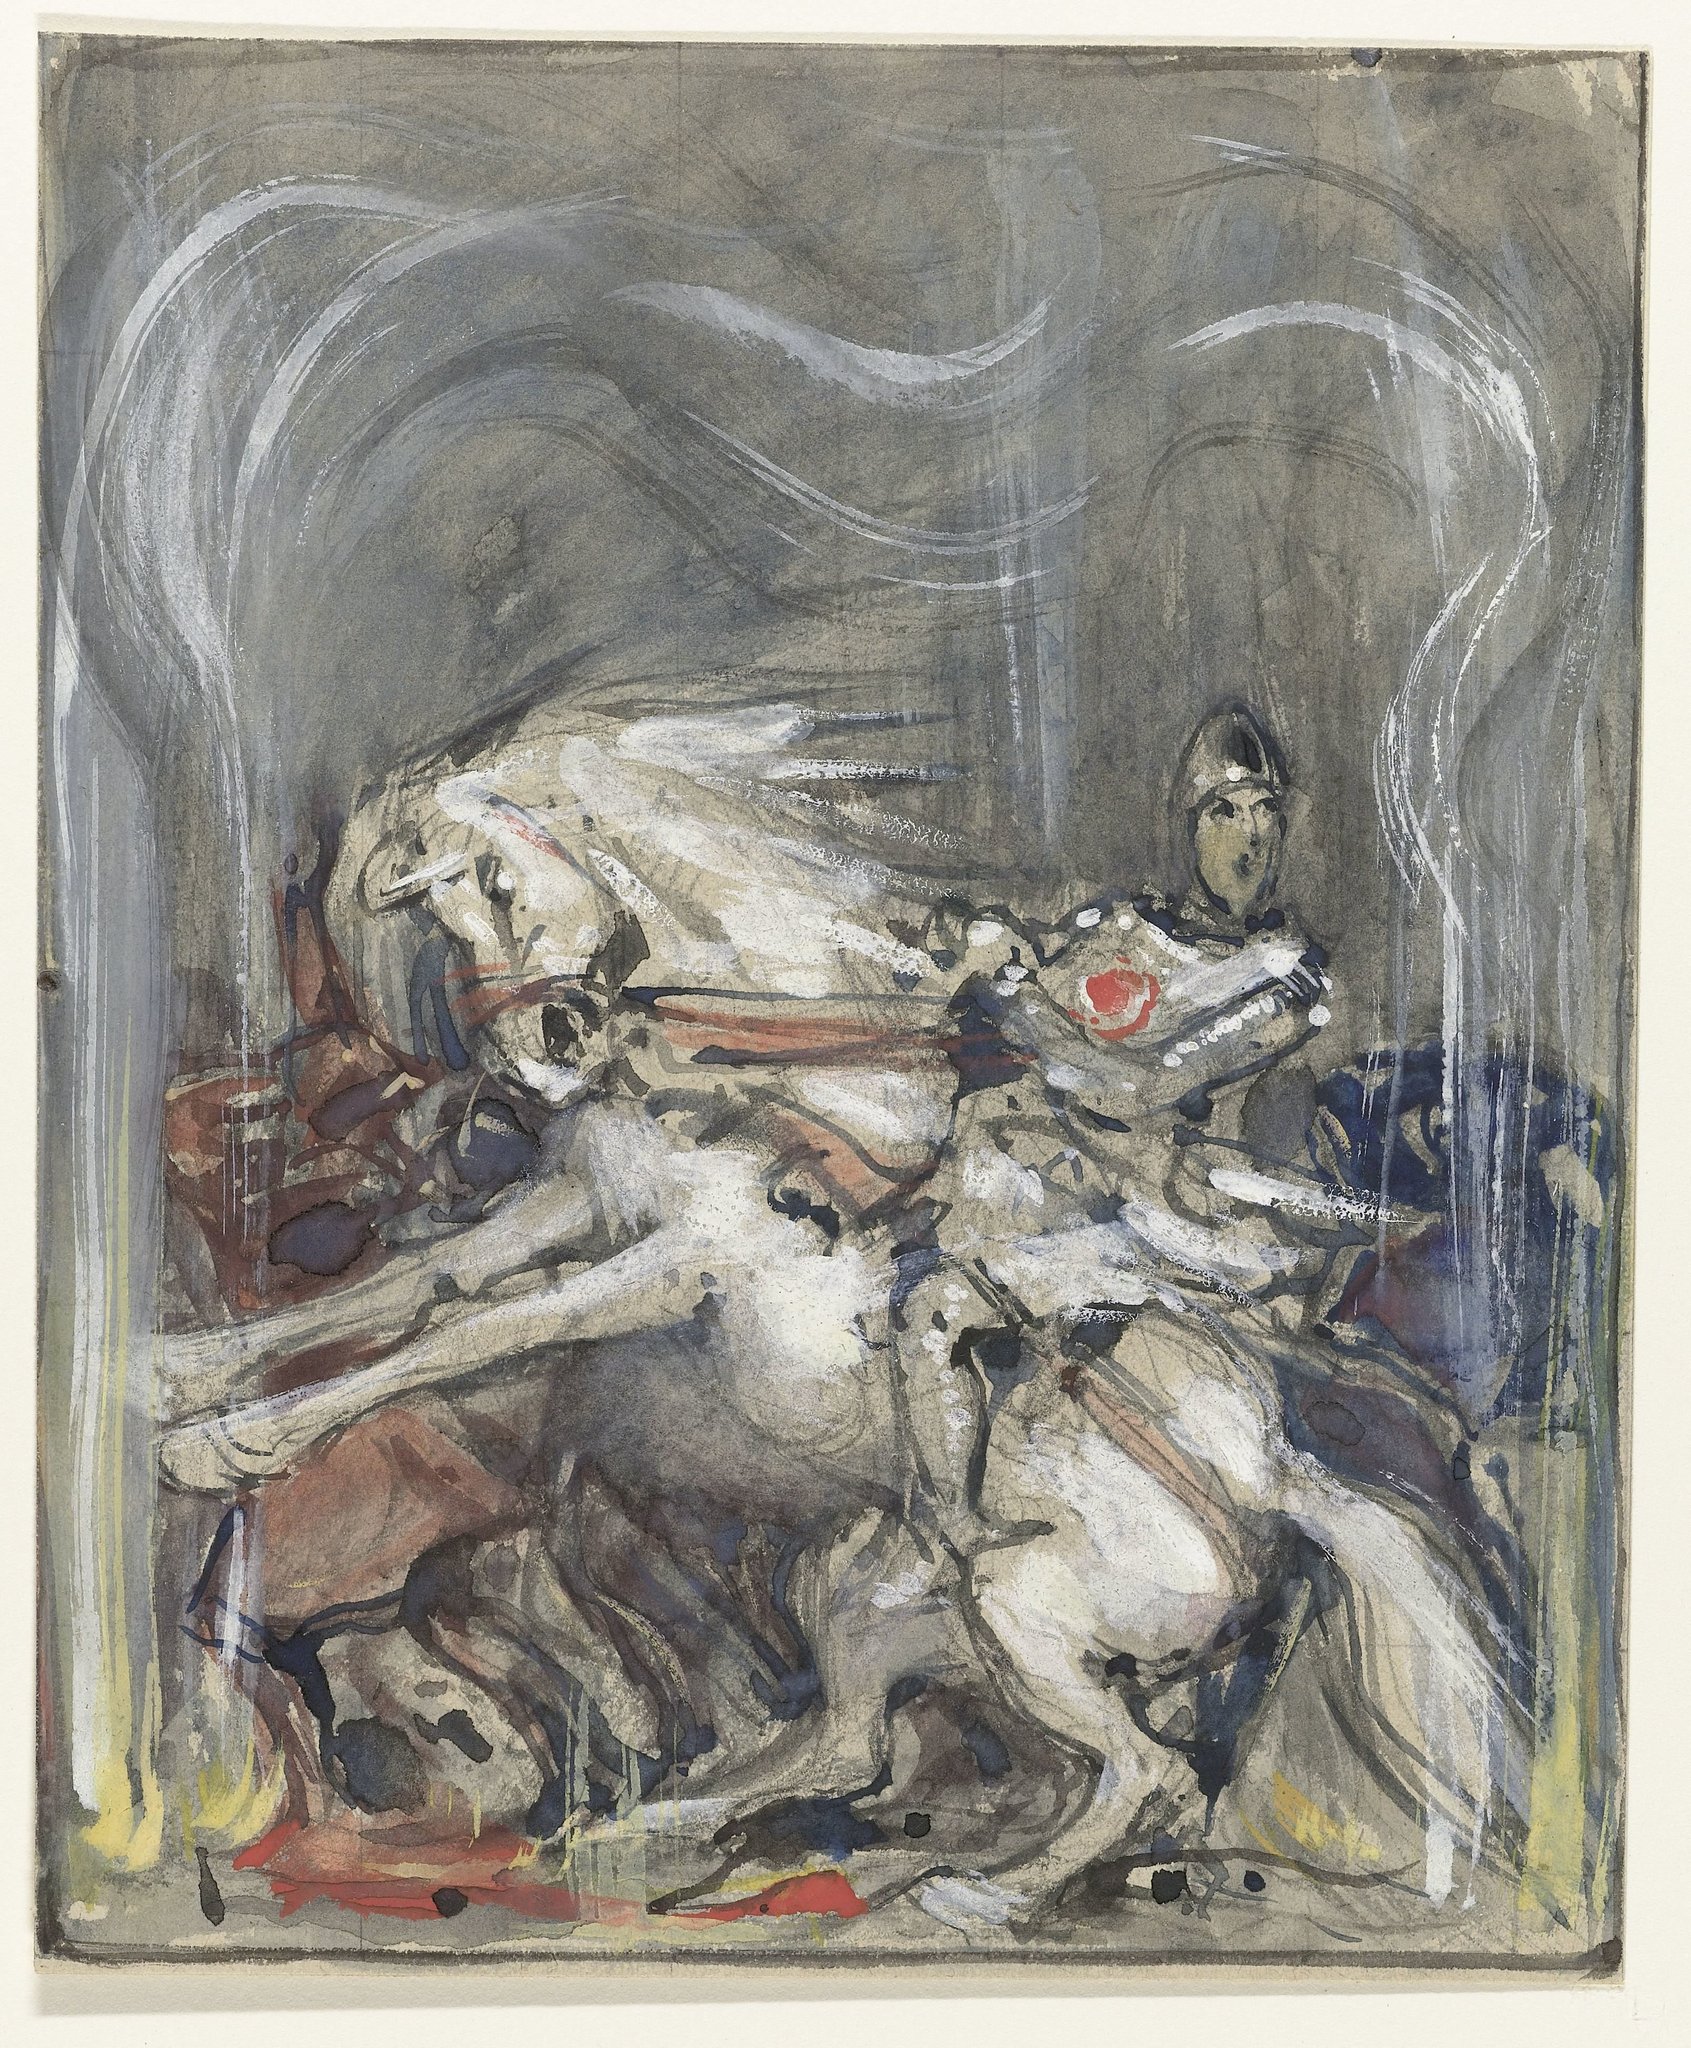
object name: drawing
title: Ruiter op steigerend paard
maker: bernard willem wierink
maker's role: draughtsman, print maker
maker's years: 1856-1939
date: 1908-1937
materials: paint, paper, pencil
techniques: brush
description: Een gehelmde ruiter in een witte tuniek op een steigerend wit paard. Achter hem soldaten te voet. In map met 31 ontwerptekeningen en schetsen voor illustraties.